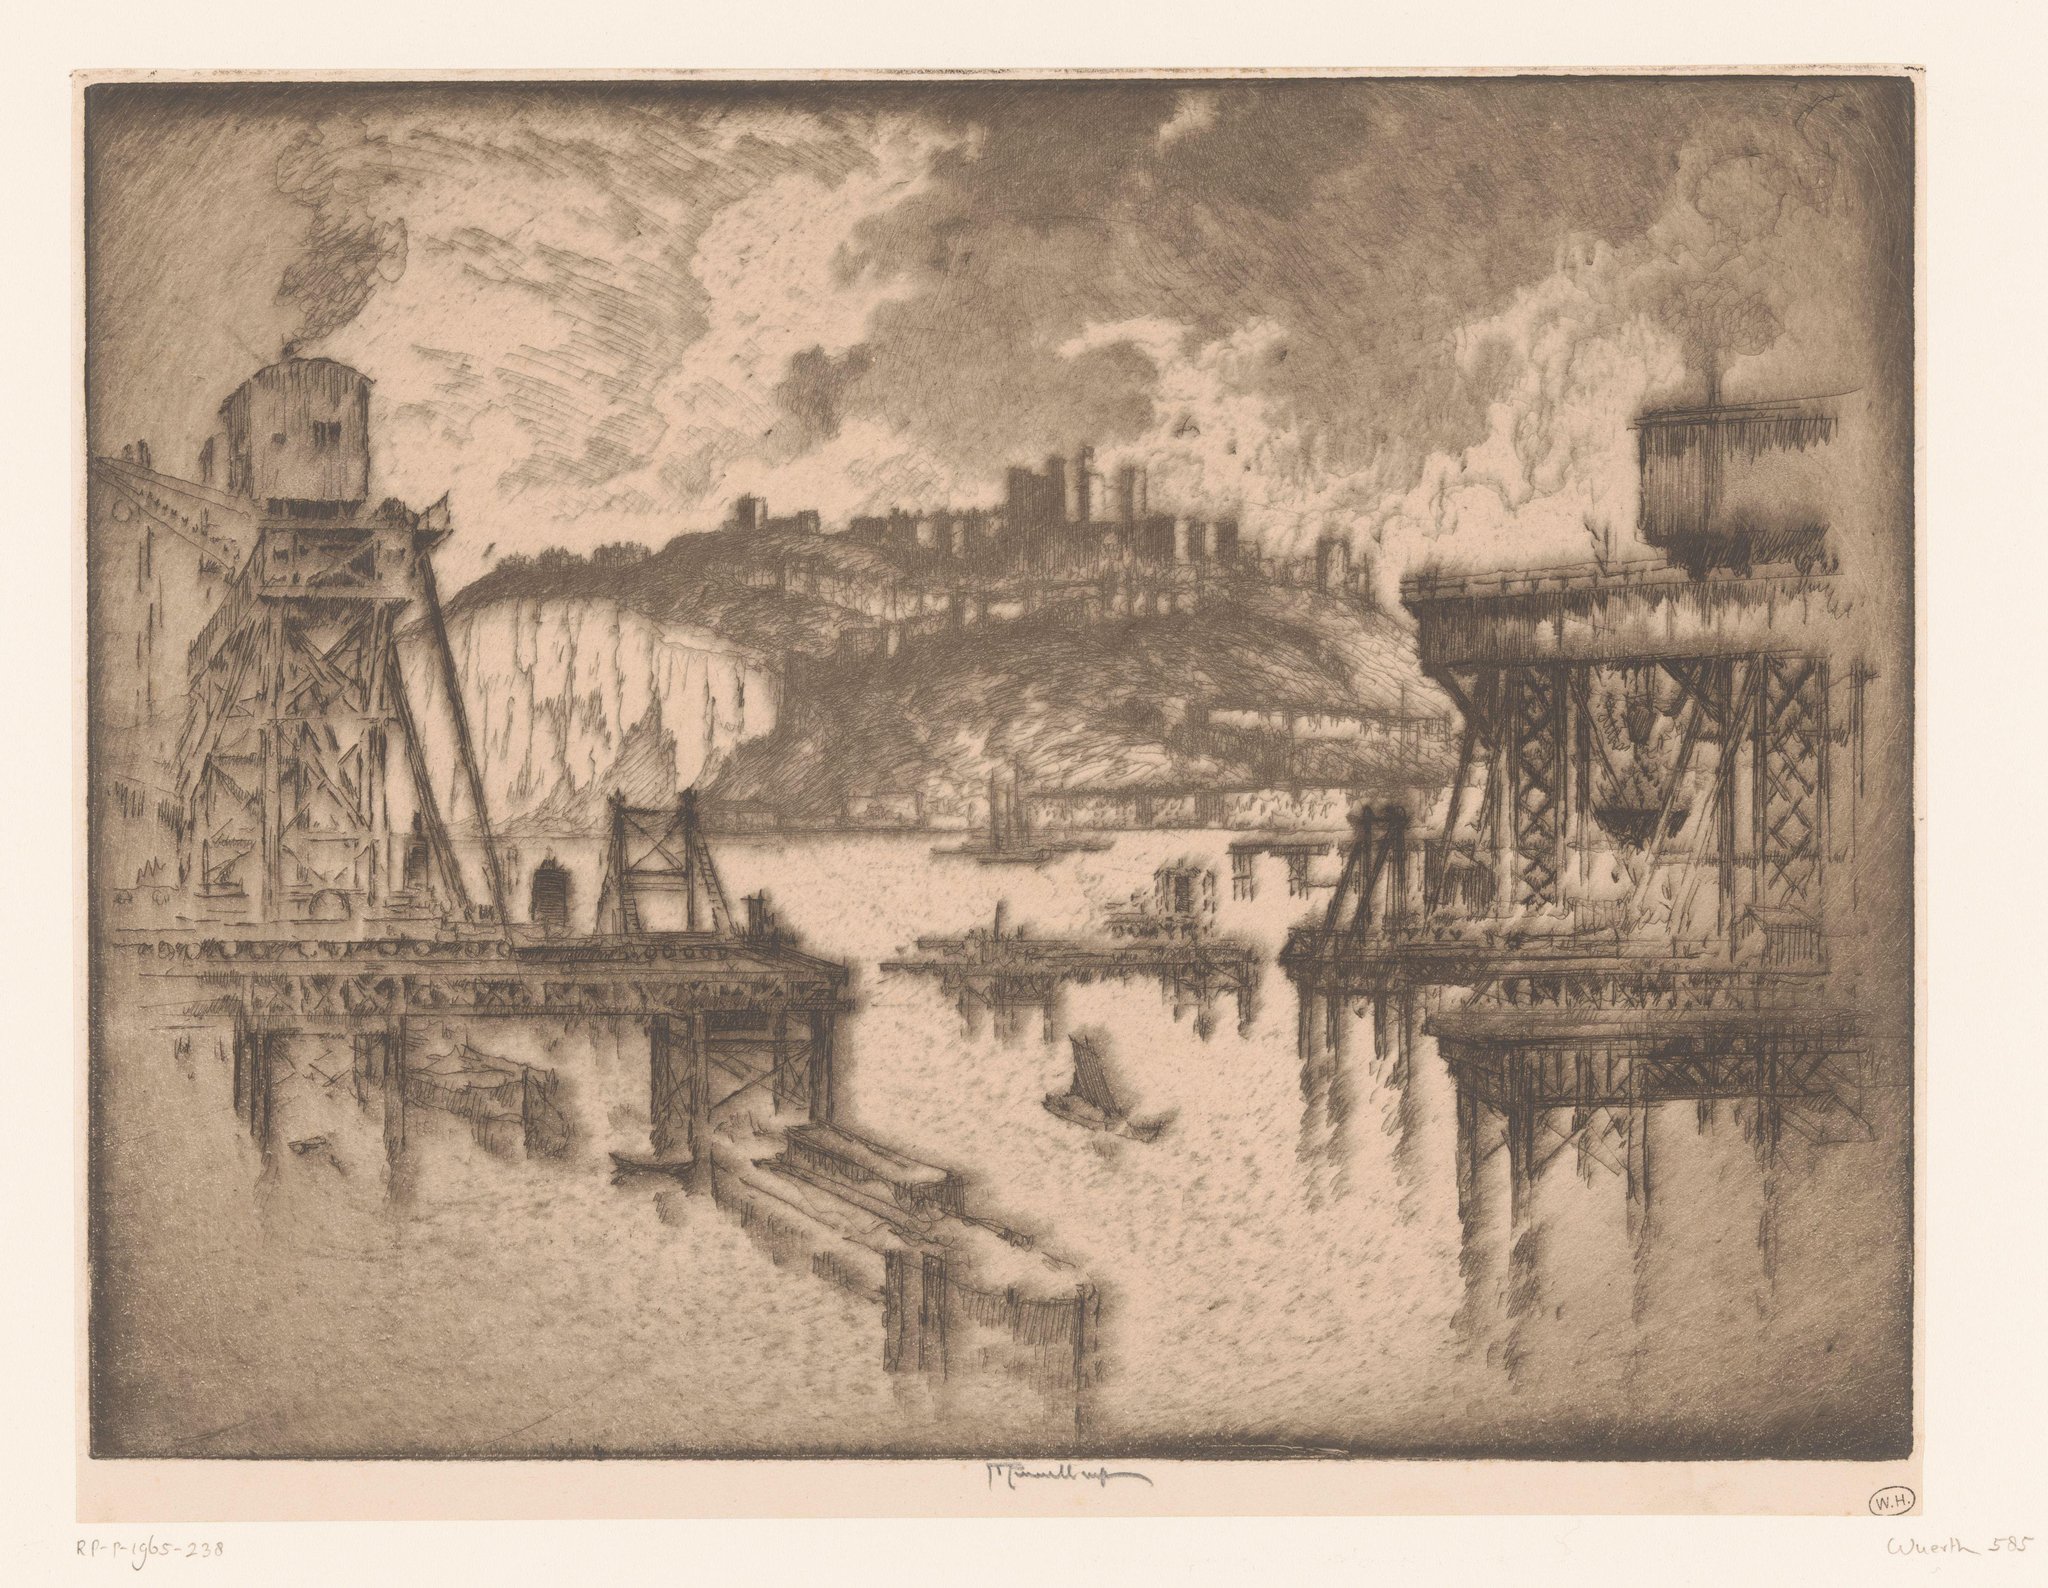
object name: print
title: Bouw van de pier bij Dover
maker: joseph pennell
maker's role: print maker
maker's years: 1857-1926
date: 1910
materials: paper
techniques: drypoint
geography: united states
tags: pier, quay, wharf, building-site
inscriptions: collector's mark: Lugt 3761, collector's mark: Lugt 2625, collector's mark: Lugt 2760, collector's mark: Lugt 2228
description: Bouwwerkzaamheden bij de aanleg van een pier bij Dover. Op de voorgrond kranen, op de achtergrond de witte kliffen.